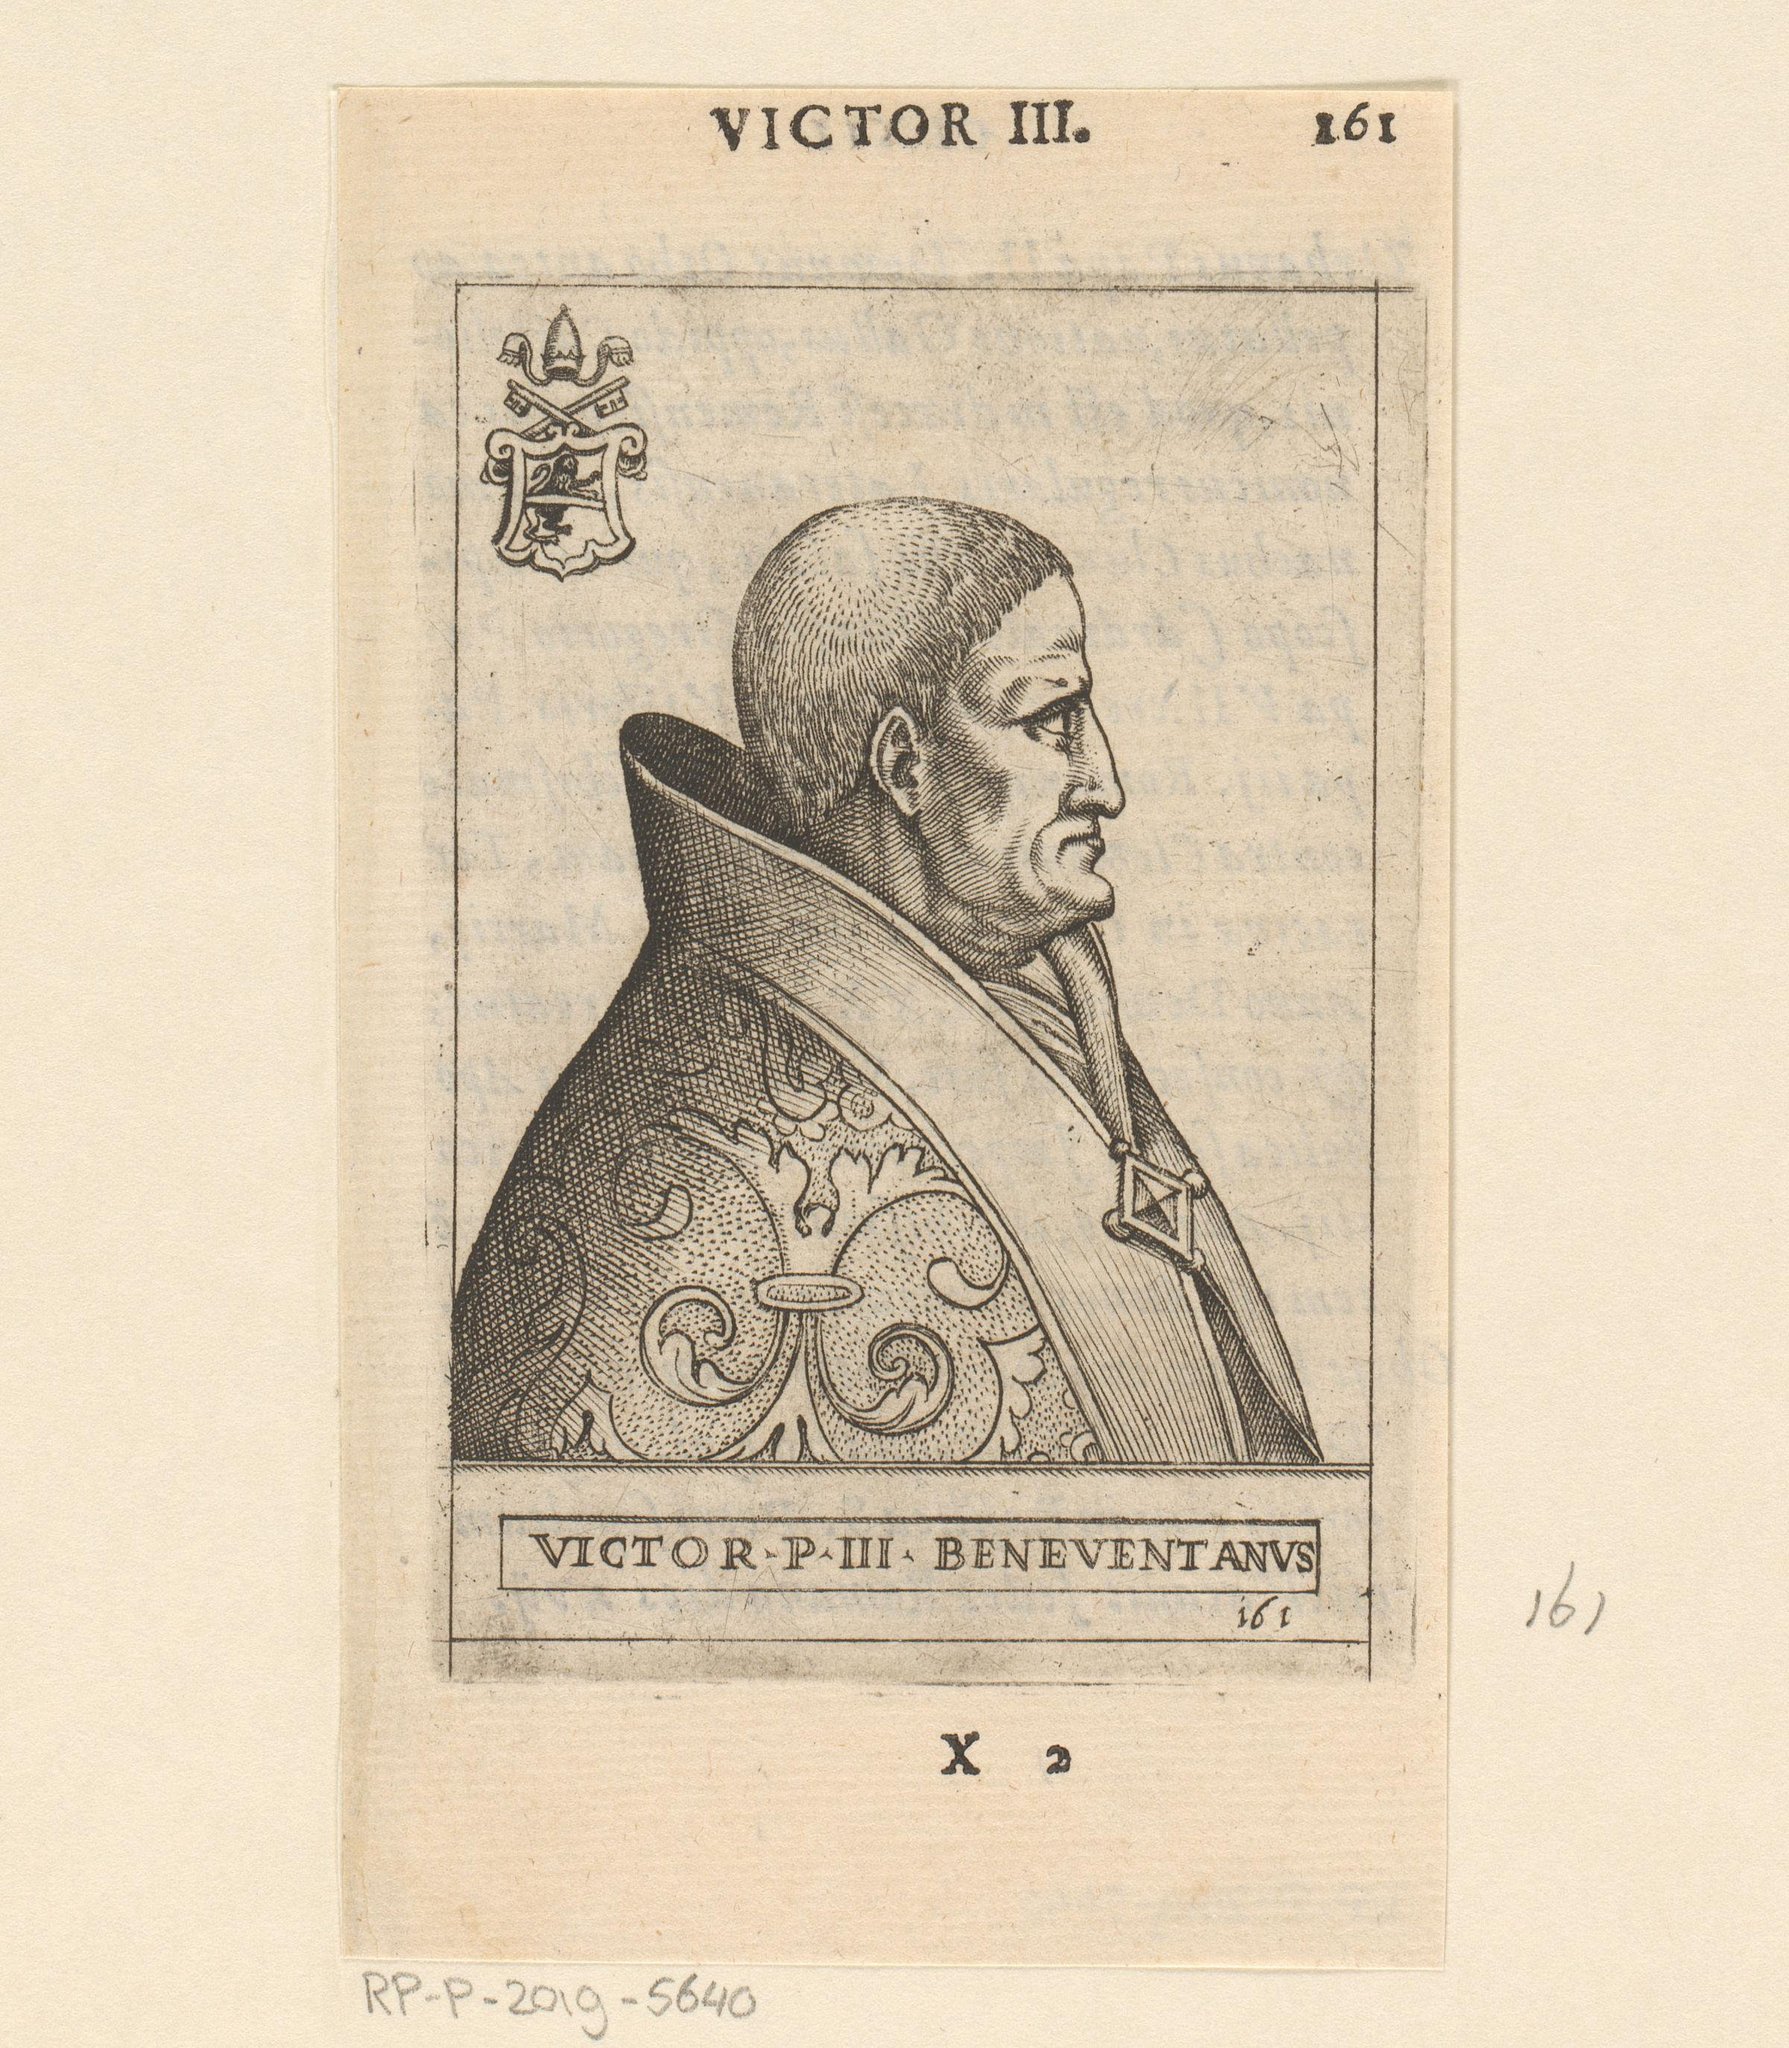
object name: print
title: Portret van paus Victor III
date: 1595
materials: paper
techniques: engraving, letterpress printing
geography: rome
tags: historical persons, pope, armorial bearing, heraldry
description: Prent uit: Cavalieri, Giovanni Battista de'. Effigies pontificum romanorum cum eorum vitis (...). Rome: Bartolomeo Bonfadino, 1595. Prent voor het eerst verschenen in: Cavalieri, Giovanni Battista de'. Pontificum romanorum effigies (...). Rome: Domenico Basa en Francesco Zanetti, 1580. Prent ook gebruikt in latere publicaties.